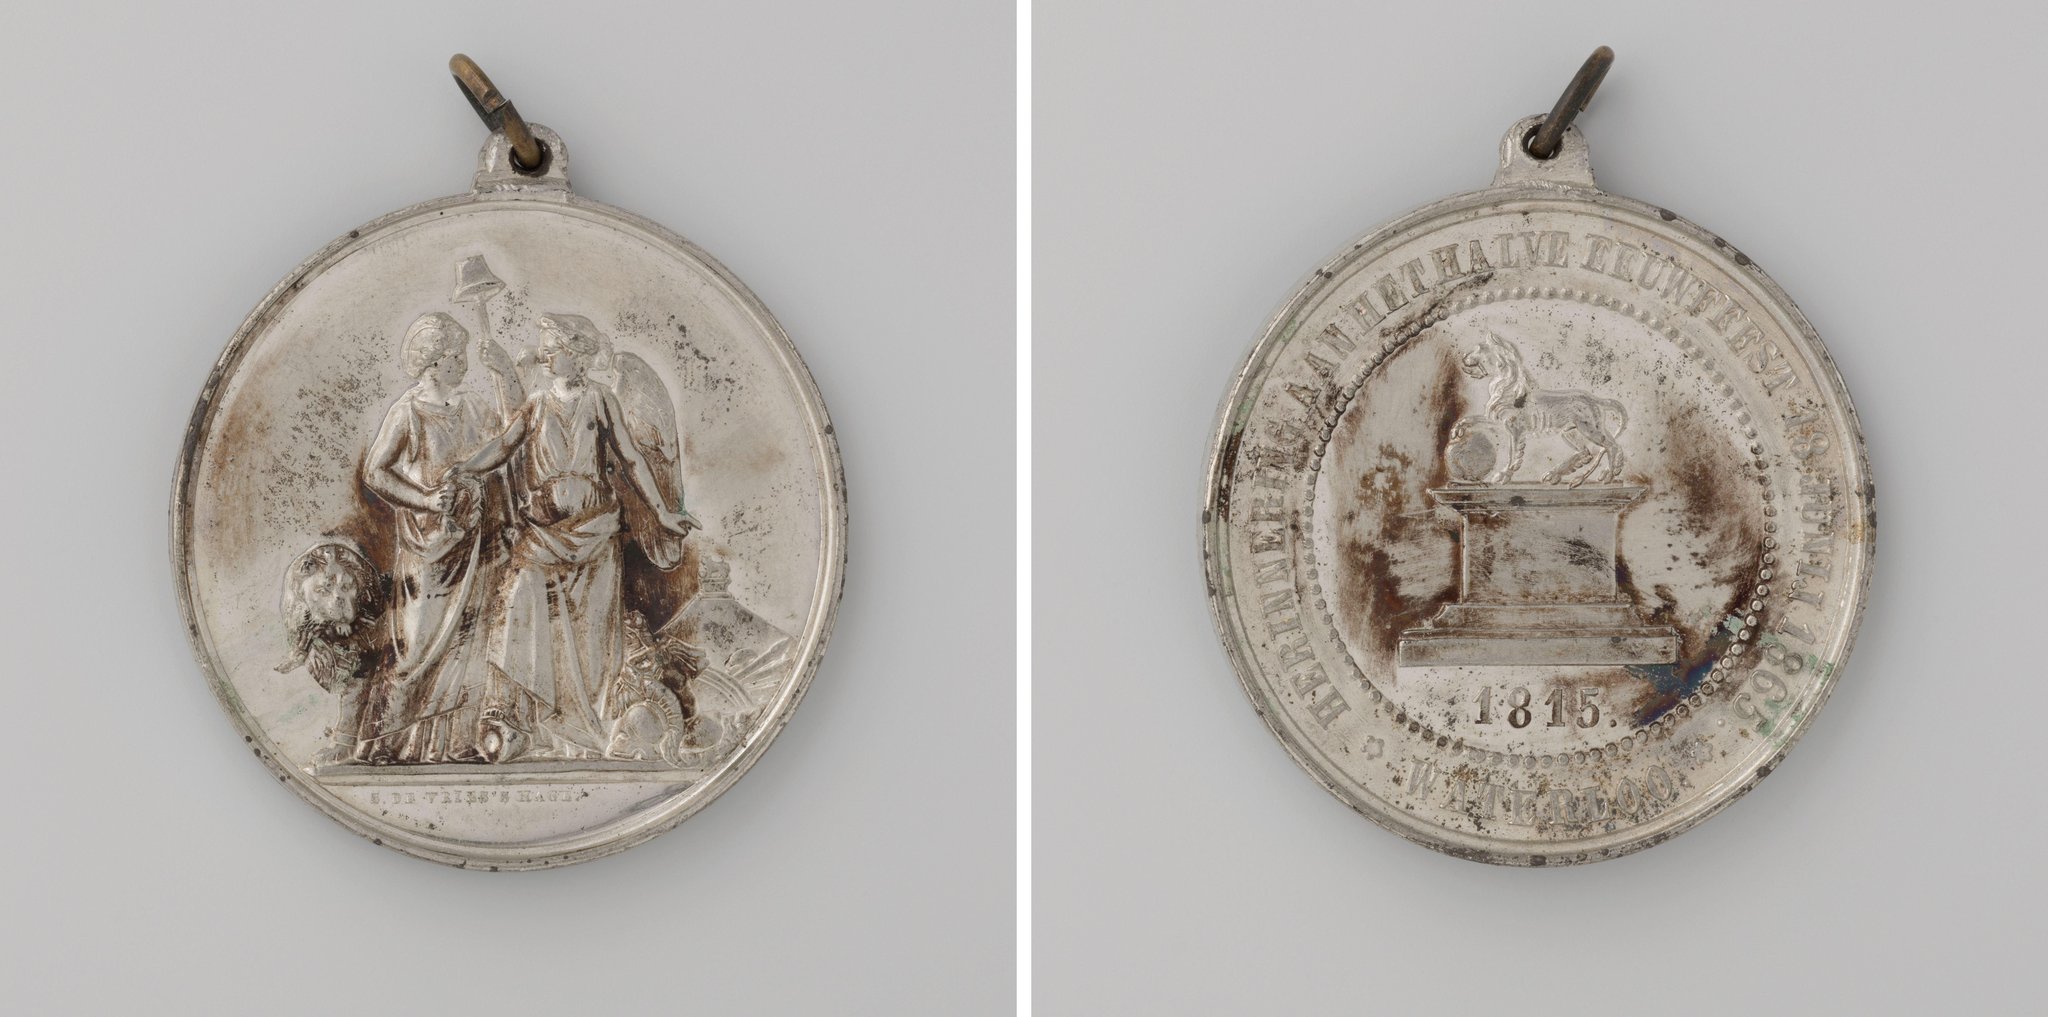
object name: history medal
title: Vijftigjarige herdenking van Nederlands onafhankelijkheid en de Slag bij Waterloo 1865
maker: salomon de vries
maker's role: graveur, medailleur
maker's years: 1830-1899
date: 1865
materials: tin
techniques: striking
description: Tinnen penning met oog en draagring, op de voorzijde Victoria die een lauwerkrans geeft aan de Nederlandse Maagd, met lans met vrijheidshoed en Nederlandse Leeuw, rechts achter het Waterloo-monument, op de keerzijde het Waterloo-monument boven het jaartal 1815, met omschrift.